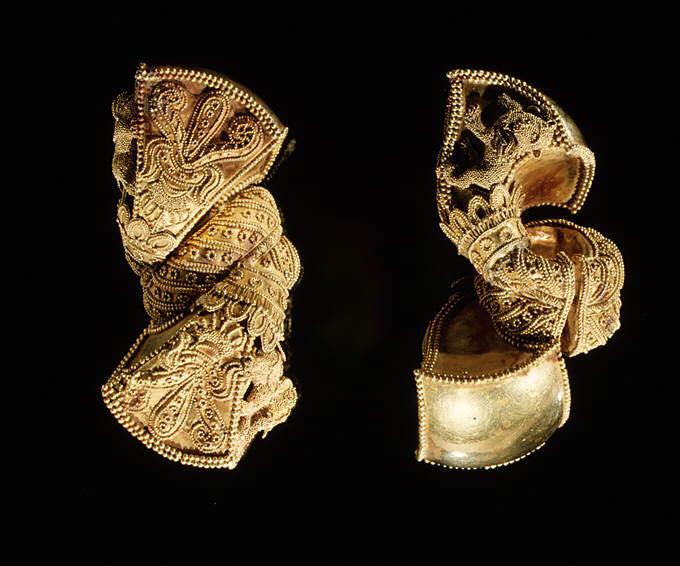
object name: wine ewer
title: A Pair of Royal Earrings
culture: indian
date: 100-1 BCE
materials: gold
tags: satavahana,elephants,lions